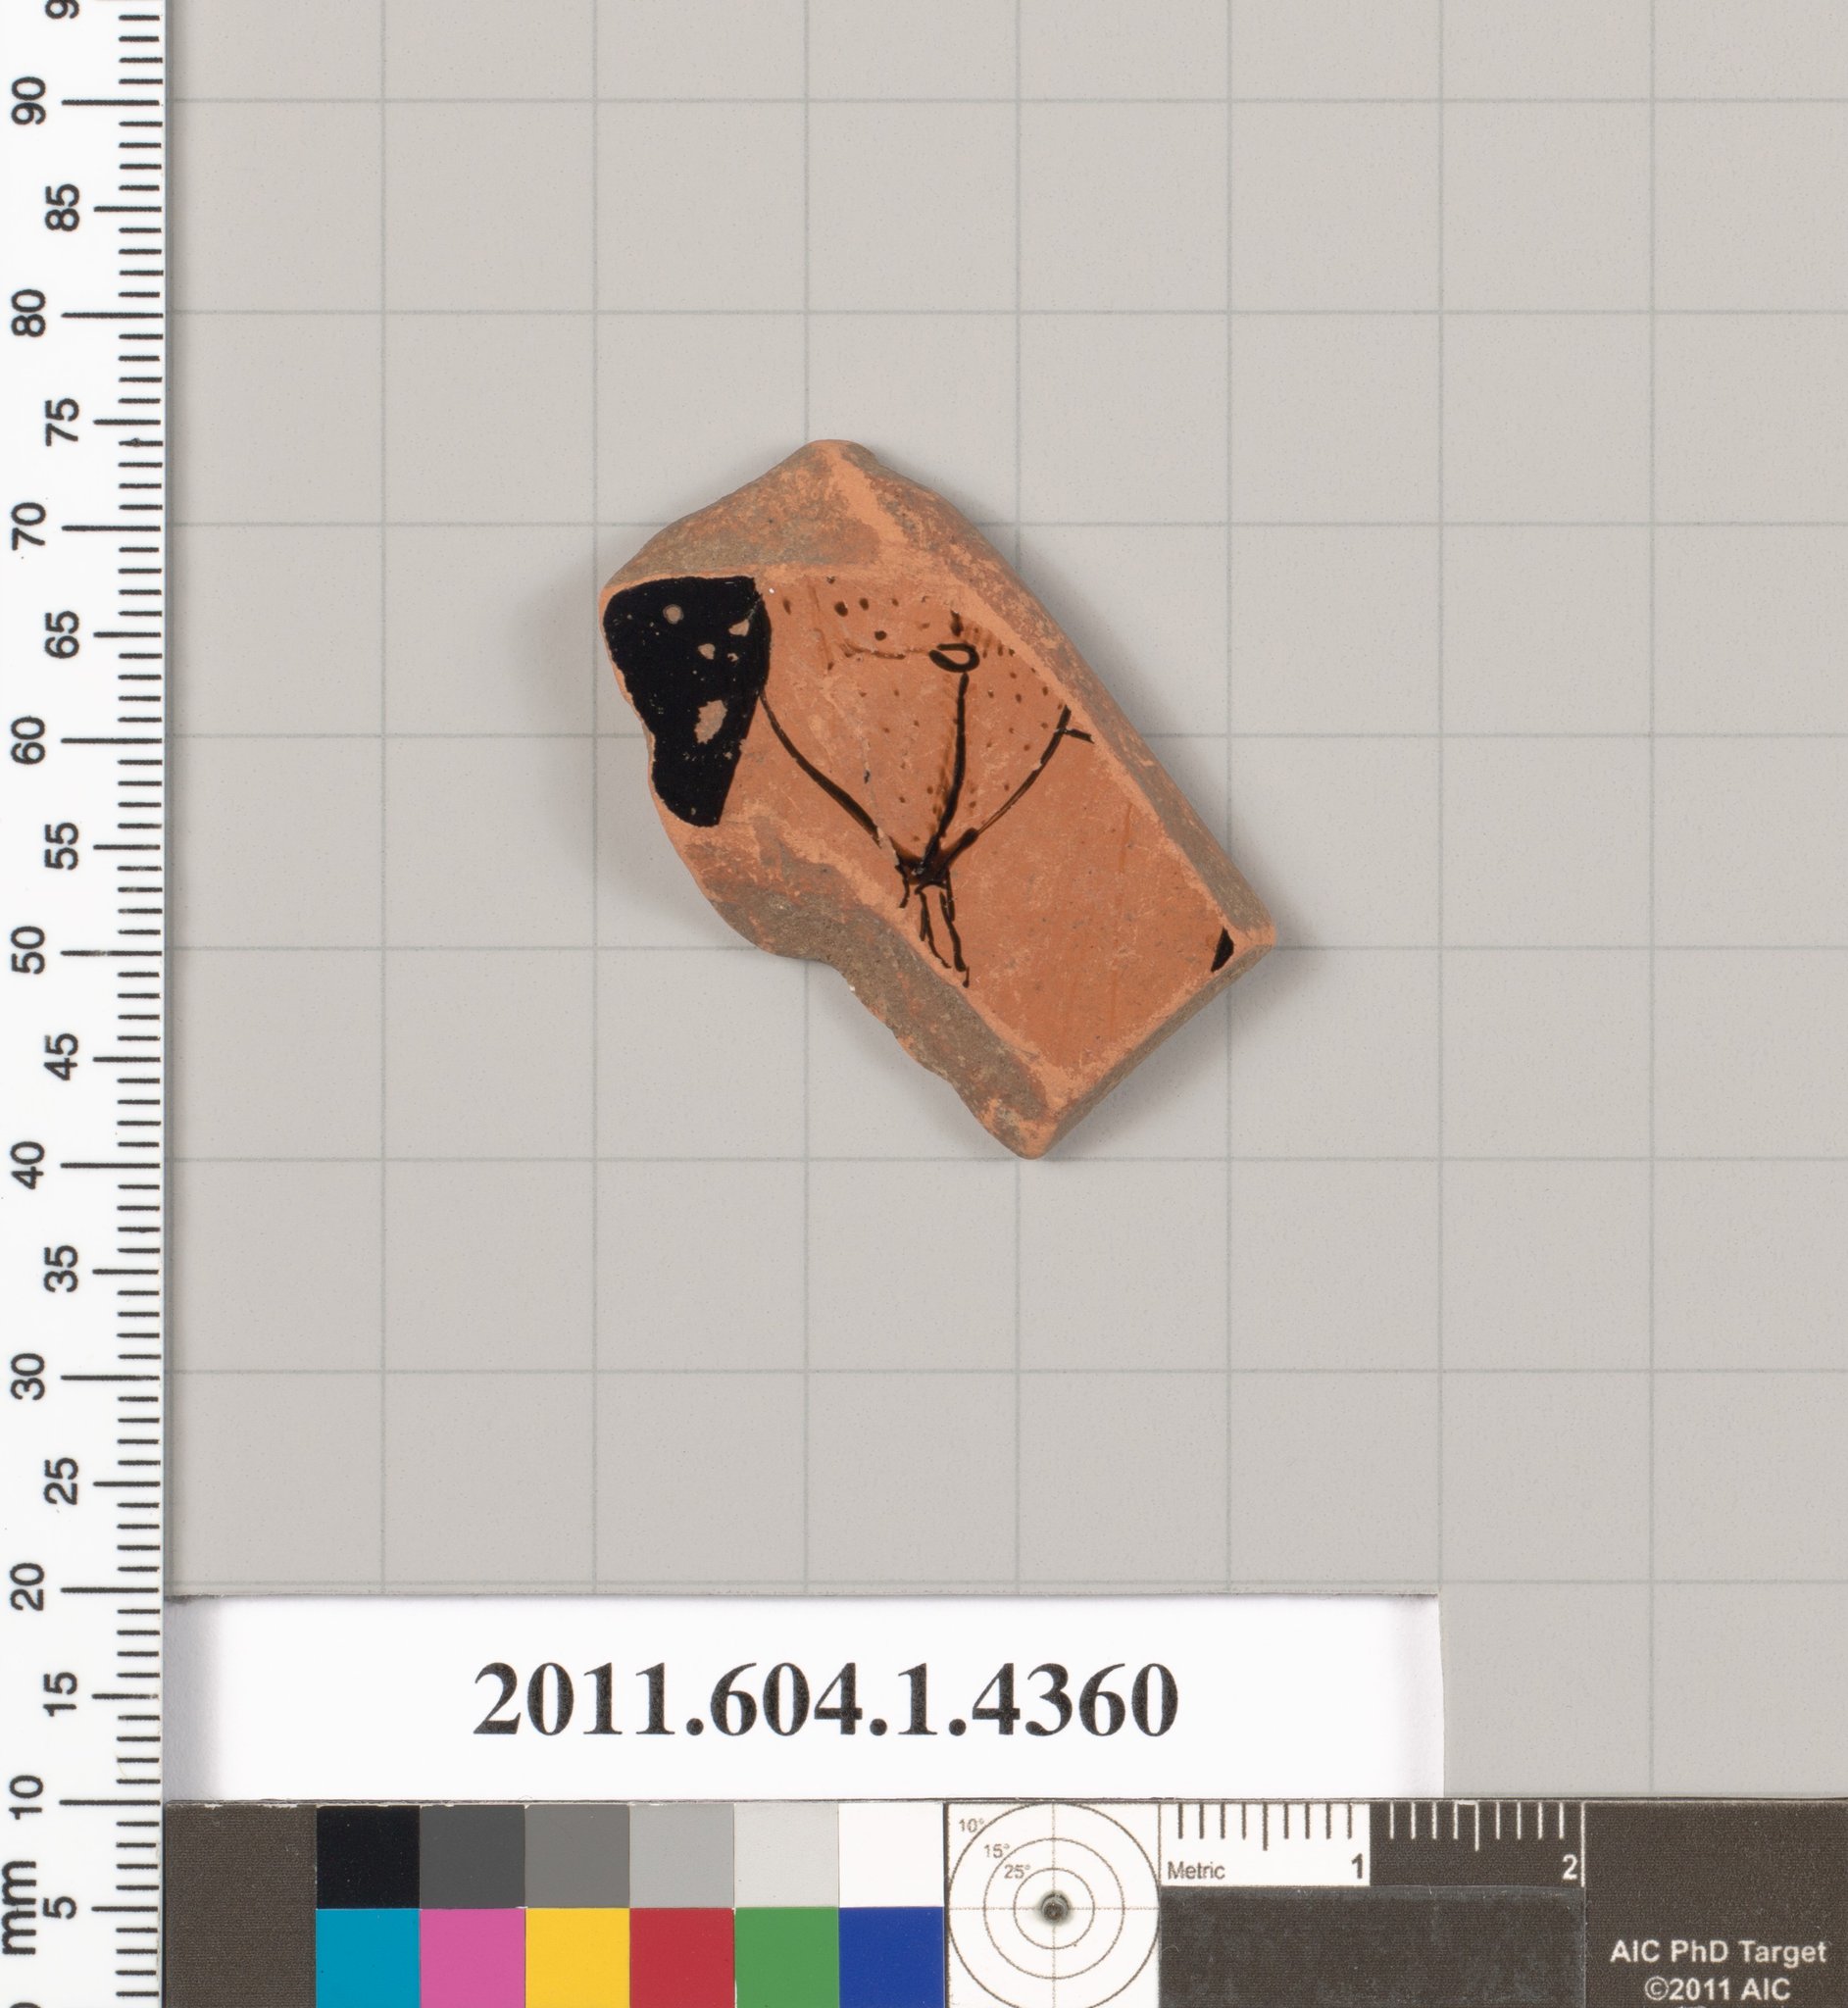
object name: kylix fragment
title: Terracotta fragment of a kylix (drinking cup)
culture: greek, attic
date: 475-451 BCE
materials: terracotta